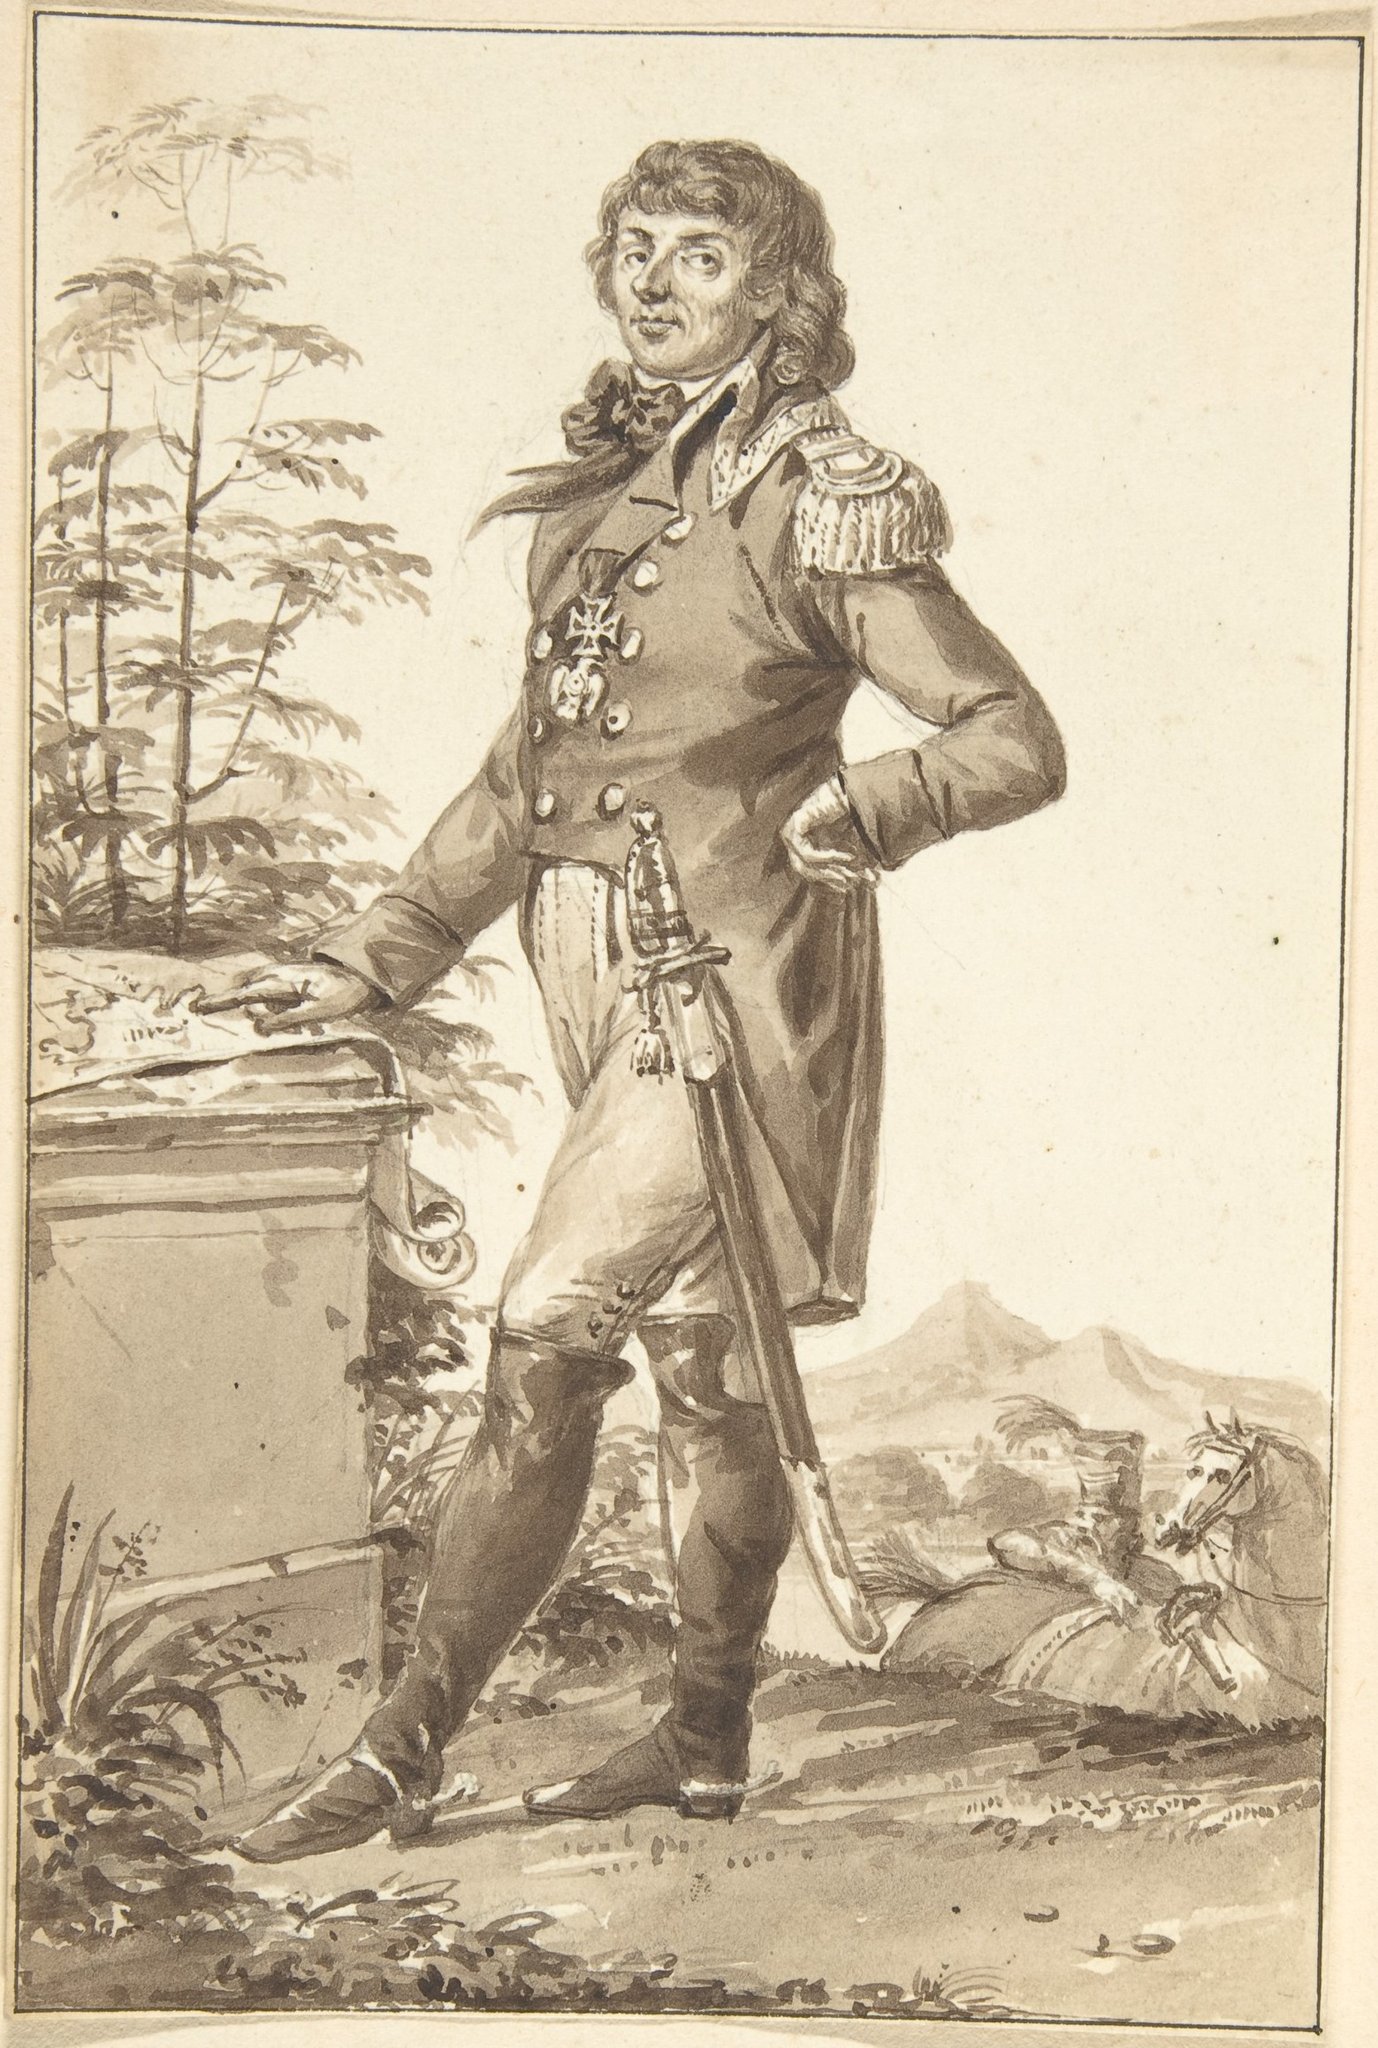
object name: drawing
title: Portrait of Thaddeus Kosciuszko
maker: jean-baptiste-françois bosio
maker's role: artist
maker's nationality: french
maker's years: 1764-1827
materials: graphite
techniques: brush, wash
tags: swords,men,portraits,horses